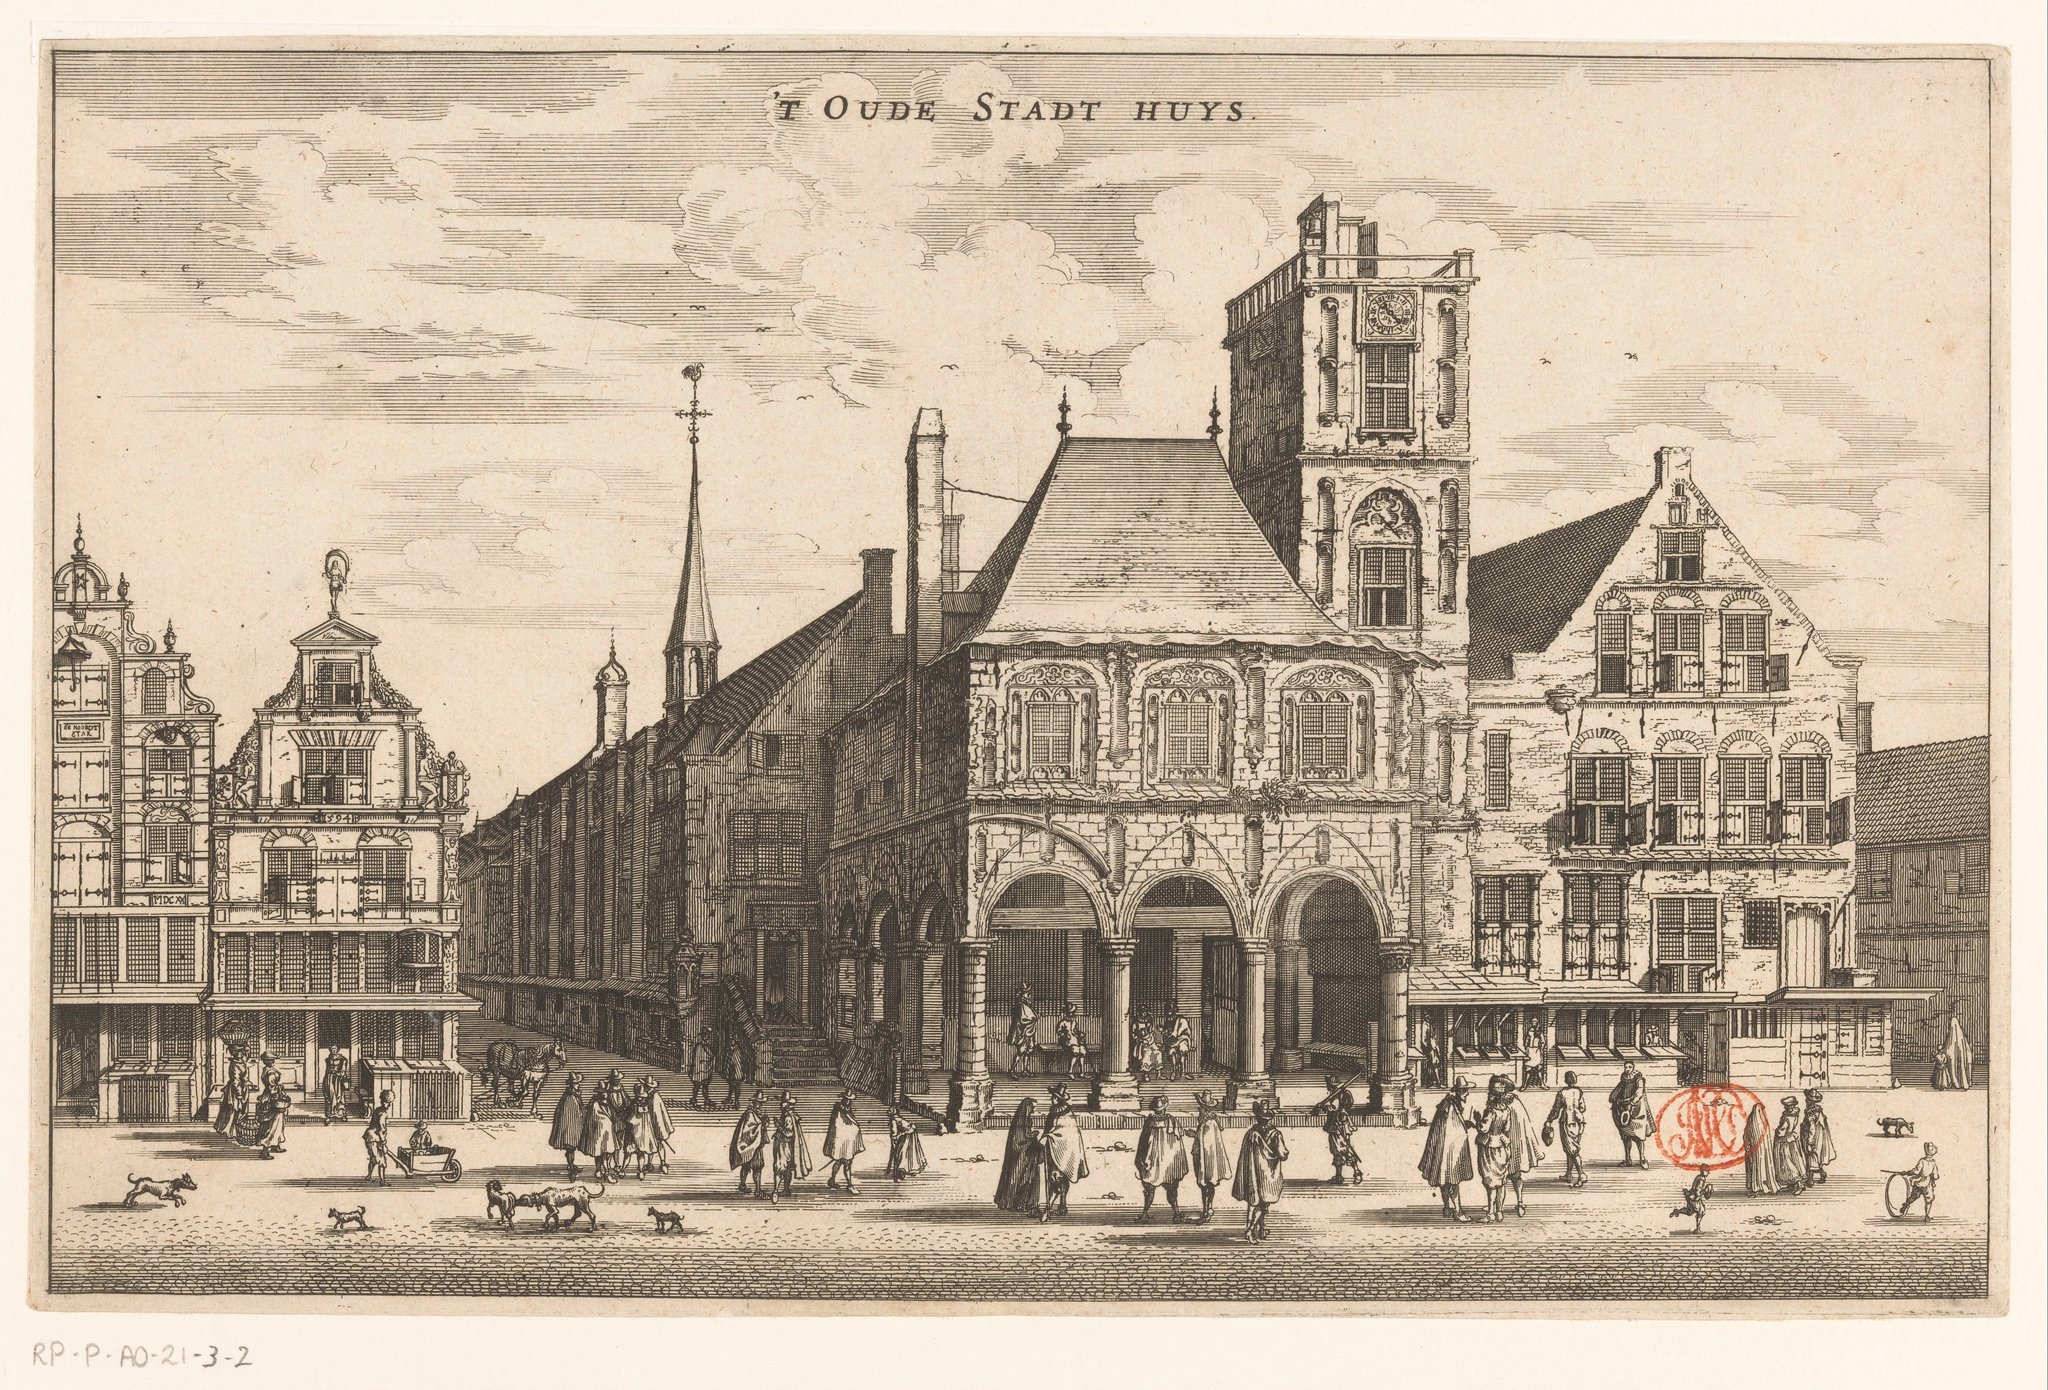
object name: book illustration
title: 't Oude Stadt huys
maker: jacob van meurs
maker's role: draughtsman, print maker, publisher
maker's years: 1619-1680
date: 1663-1664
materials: paper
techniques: engraving, etching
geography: amsterdam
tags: townhall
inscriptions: collector's mark: Lugt 195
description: Huidige staat van prent ook gebruikt in: Dapper, Olfert. Historische beschryving der stadt Amsterdam: waer in de voornaemste geschiedenissen (na een kort verhael van gansch Hollant en d'omleggende dorpen (…). Amsterdam: Jacob van Meurs, 1663.* En in: Zesen, Philipp von. Beschreibung der Stadt Amsterdam: darinnen von derselben ersten Ursprunge bis auf gegenwärtigen Zustand (…). Amsterdam: Joachim Nosche, 1664. * In sommige exemplaren van deze uitgave komt de huidige staat van de prent voor. In andere exemplaren is een latere staat ingebonden, waarop boven de Nederlandse een Franse titel is toegevoegd.